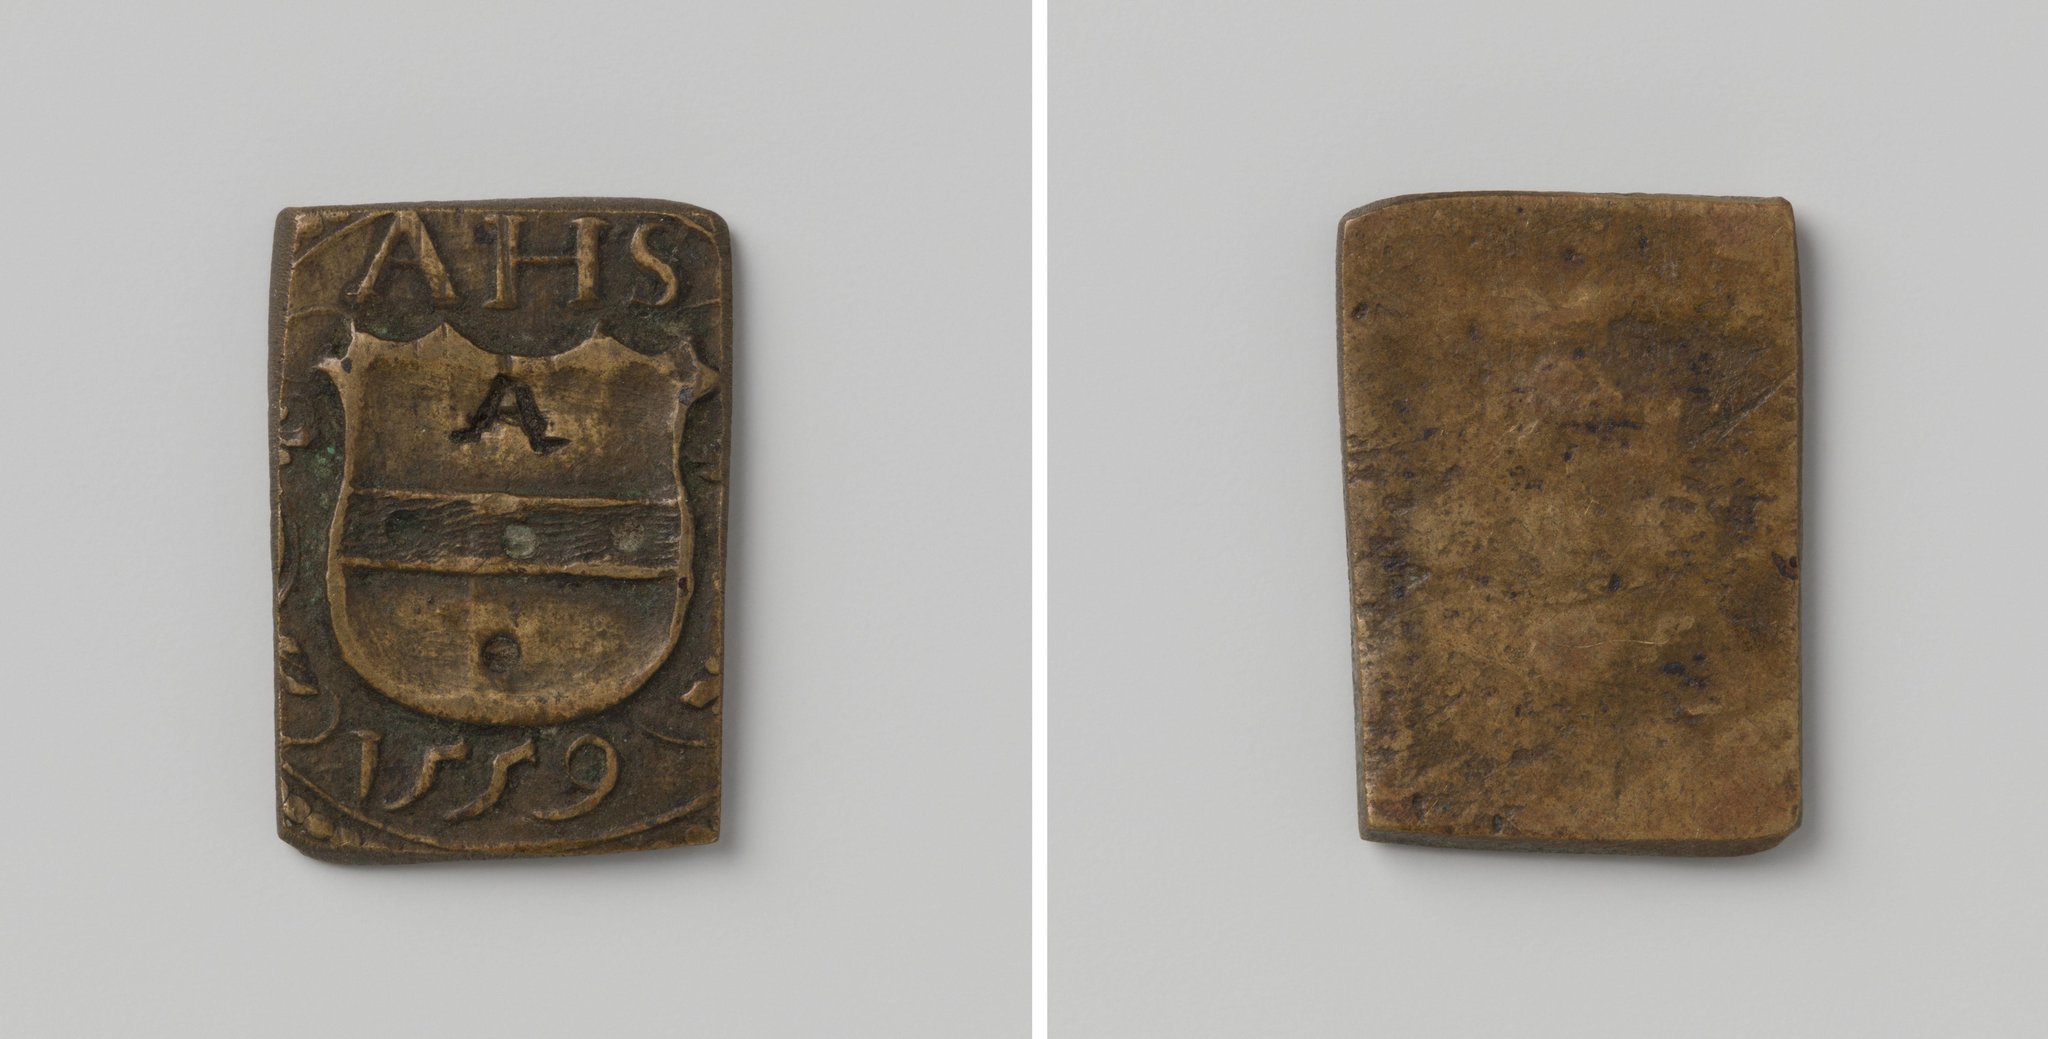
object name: medal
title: Penning met opschrift AHS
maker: Anonymous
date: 1559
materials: brass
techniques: striking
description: Eenzijdige messing penning, aan beide zijden afgesneden tot een rechthoek. Voorzijde: in gedeeltelijk bewaard gebleven cirkel: monogram van de letters AHS boven wapenschild omgeven door slechts ten dele zichtbare takjes en jaartal; ingeslagen in bovenste deel van wapenschild: letter A, op balk drie stippen en in onderste deel een stip. Keerzijde: blanco